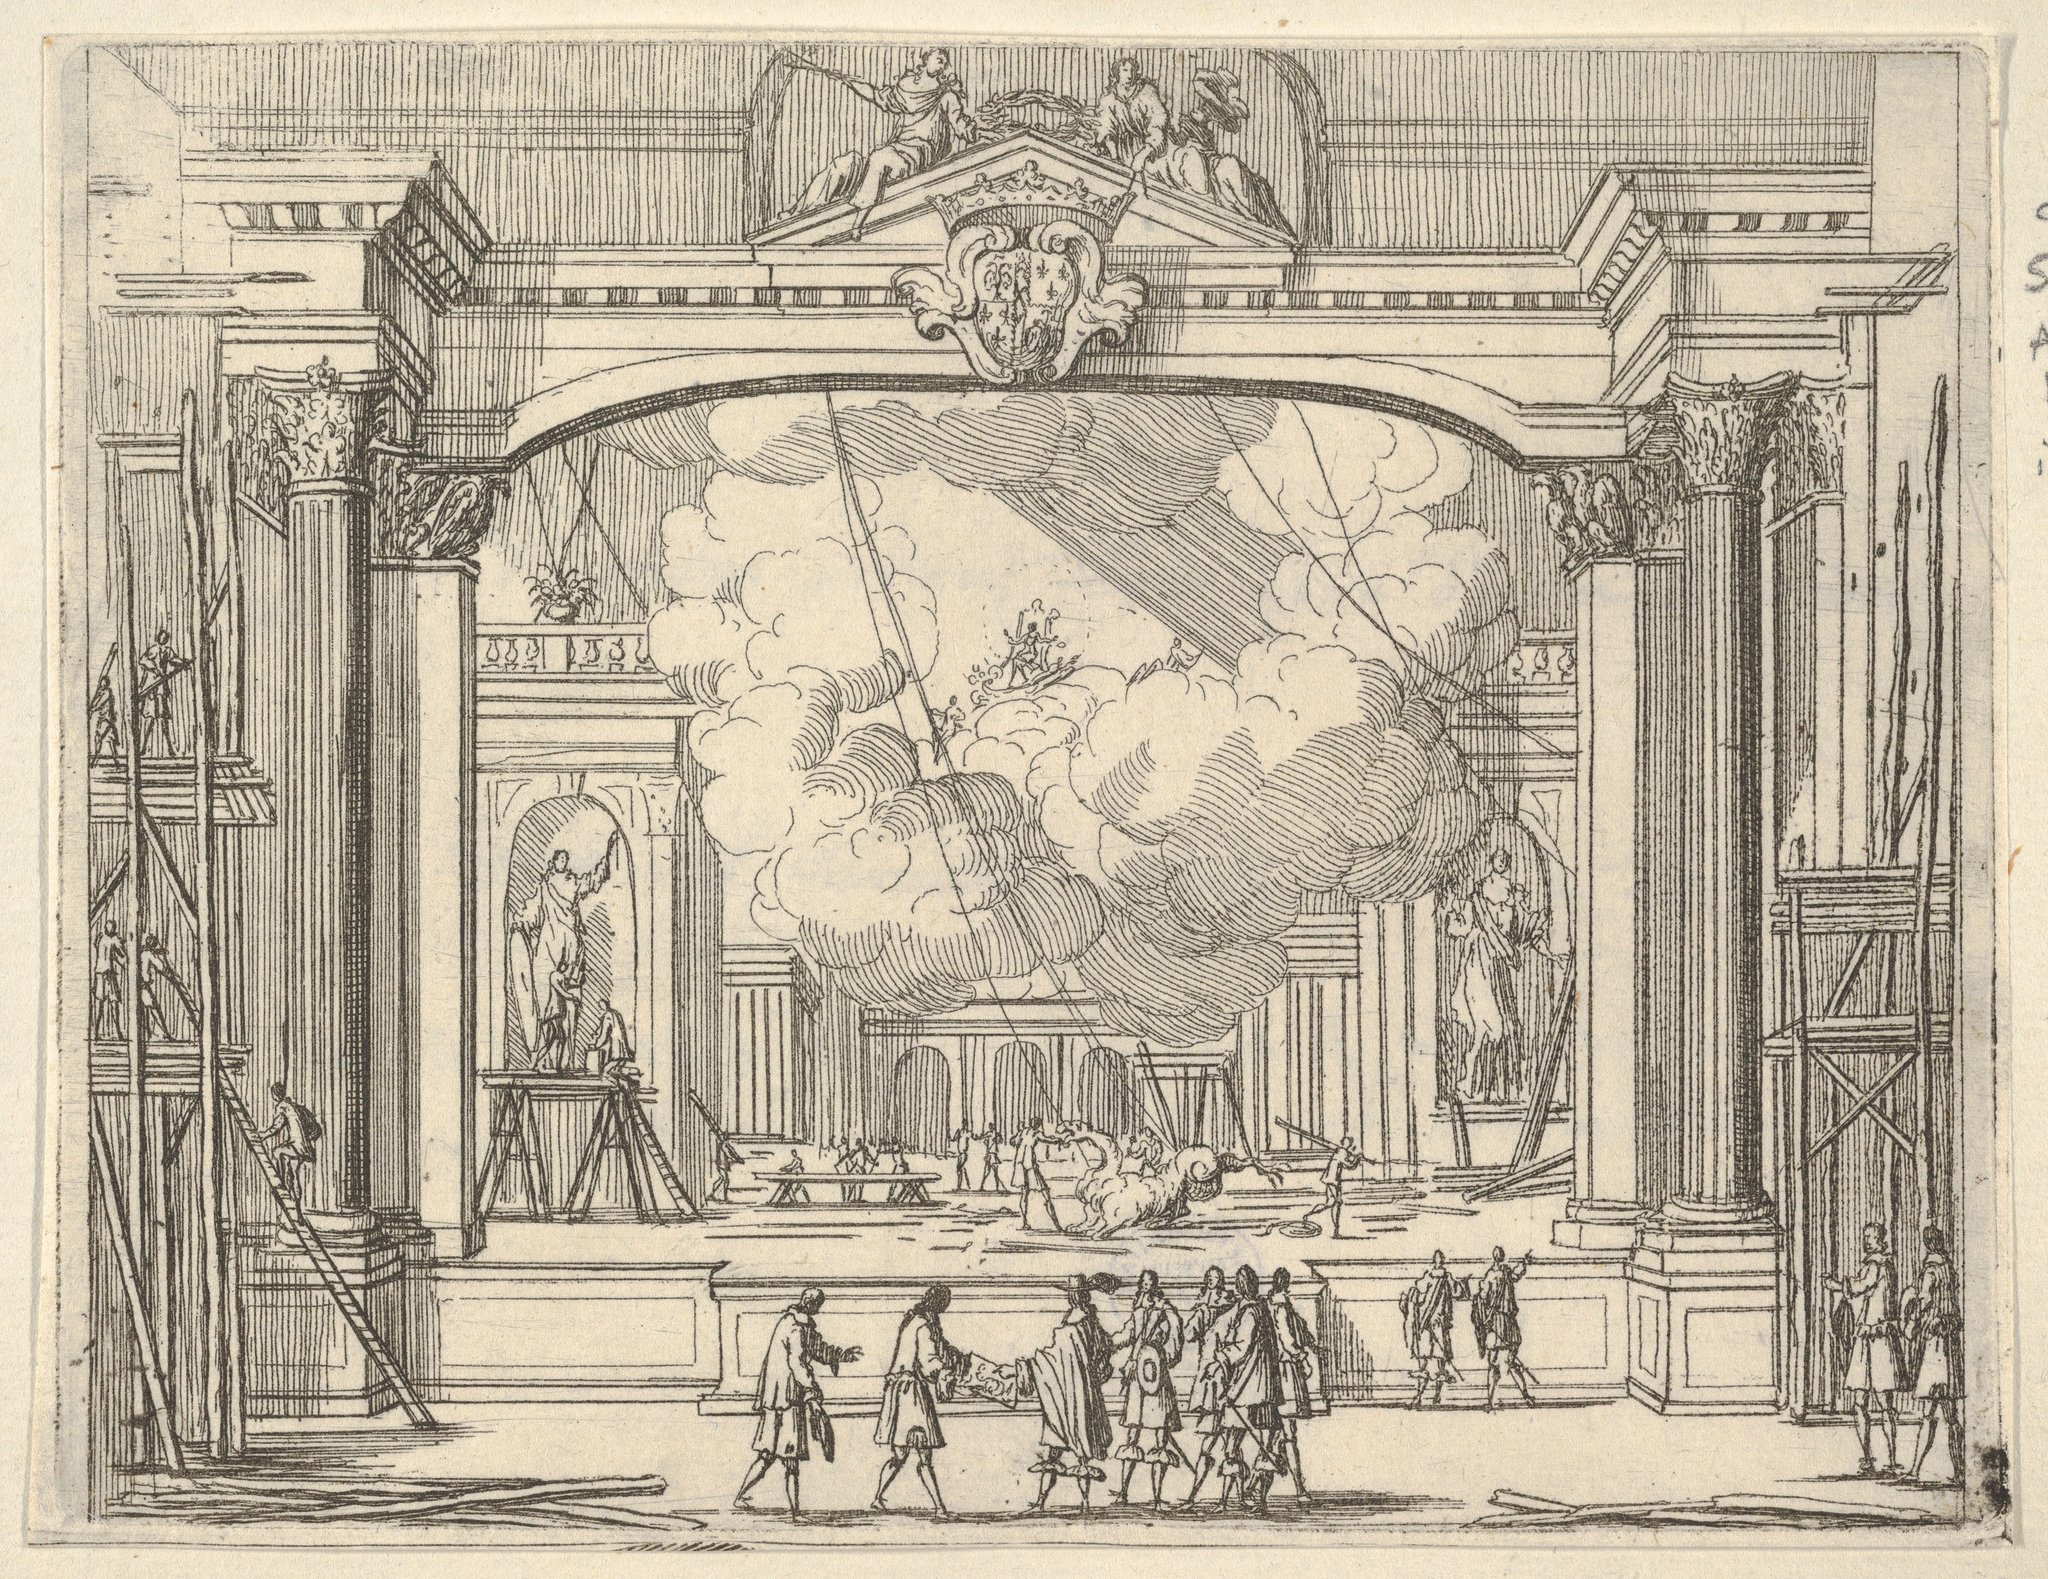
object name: print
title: Francesco I d'Este Orders Fête Decorations, from "L'Idea di un Principe ed Eroe Cristiano in Francesco I d'Este, di Modena e Reggio Duca VIII [...]"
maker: bartolomeo fenice (fénis)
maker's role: artist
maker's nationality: italian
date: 1659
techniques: etching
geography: italy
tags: men,working